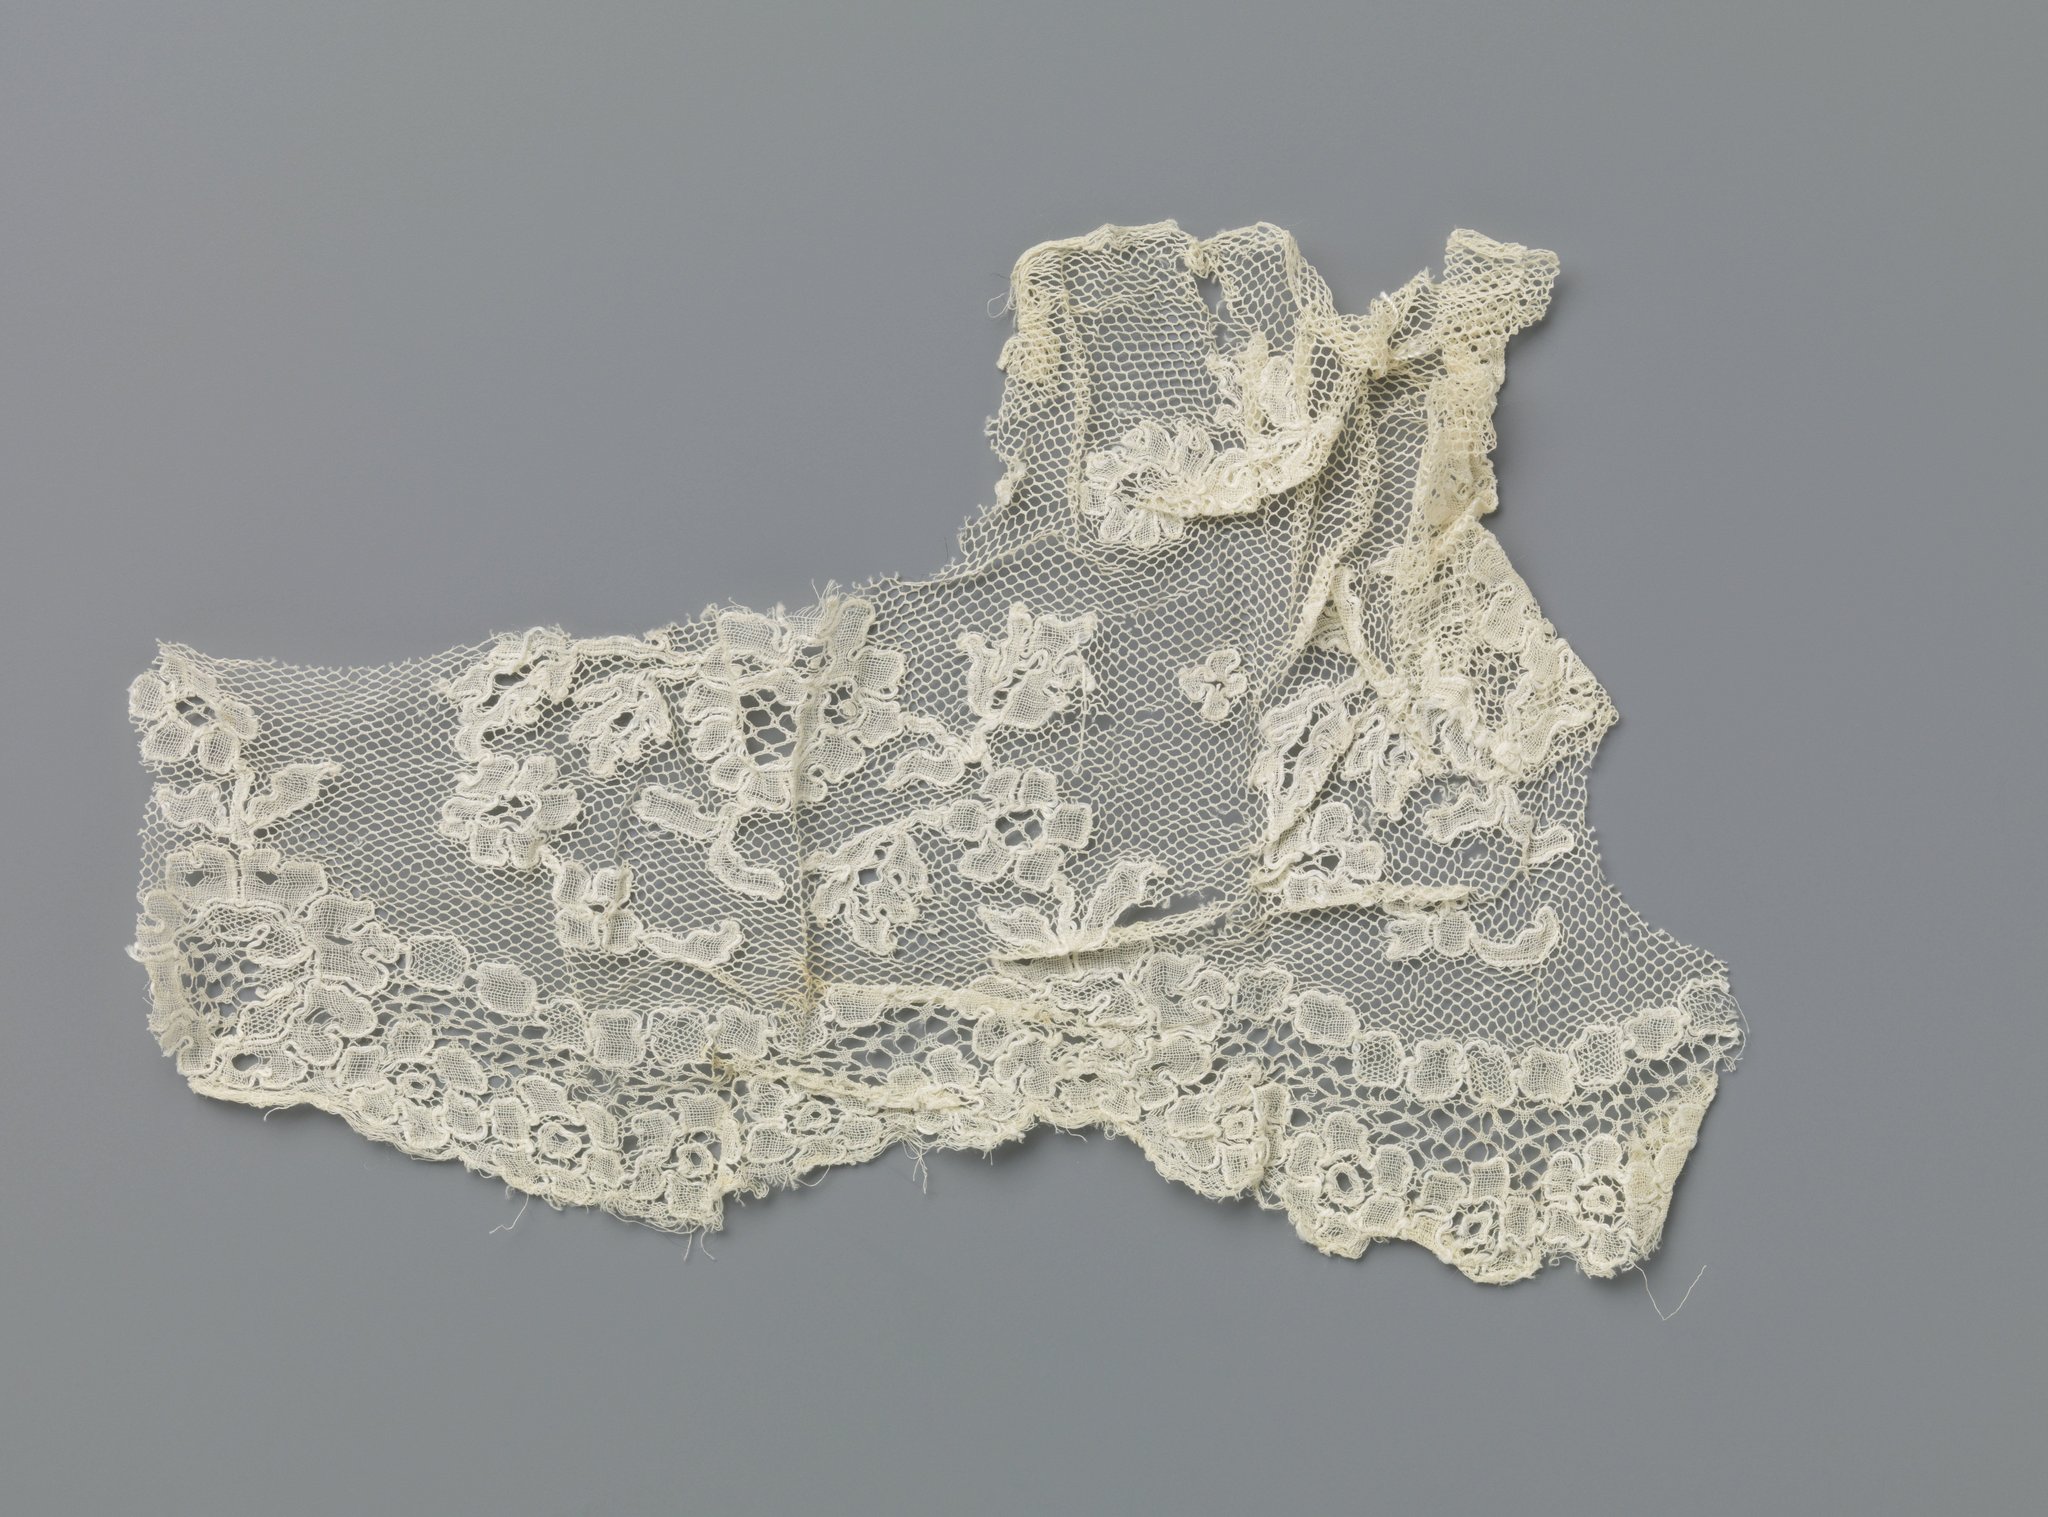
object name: strip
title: Strook kloskant met parel- en rozetlijst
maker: Anonymous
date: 1830-1850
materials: linen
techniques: lace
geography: ieper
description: Op de traliegrond, een Mechelse grond (ook wel ijsgrond genoemd), met enkele gestrooide vierpasvormige moesjes staat een lopend patroon. Langs de binnenkant staan kleine hangende rozetakjes, in het midden een duinroosje aan grotere voluutstengels, die ontspringen bij dezelfde bloem die het sluitstuk der zuiver cirkelboogvormige schulpen vormt. De schulpen bestaan uit een parel- en rozetlijst, die een middenbaan met rasterwerk insluiten. Mechelse kant.